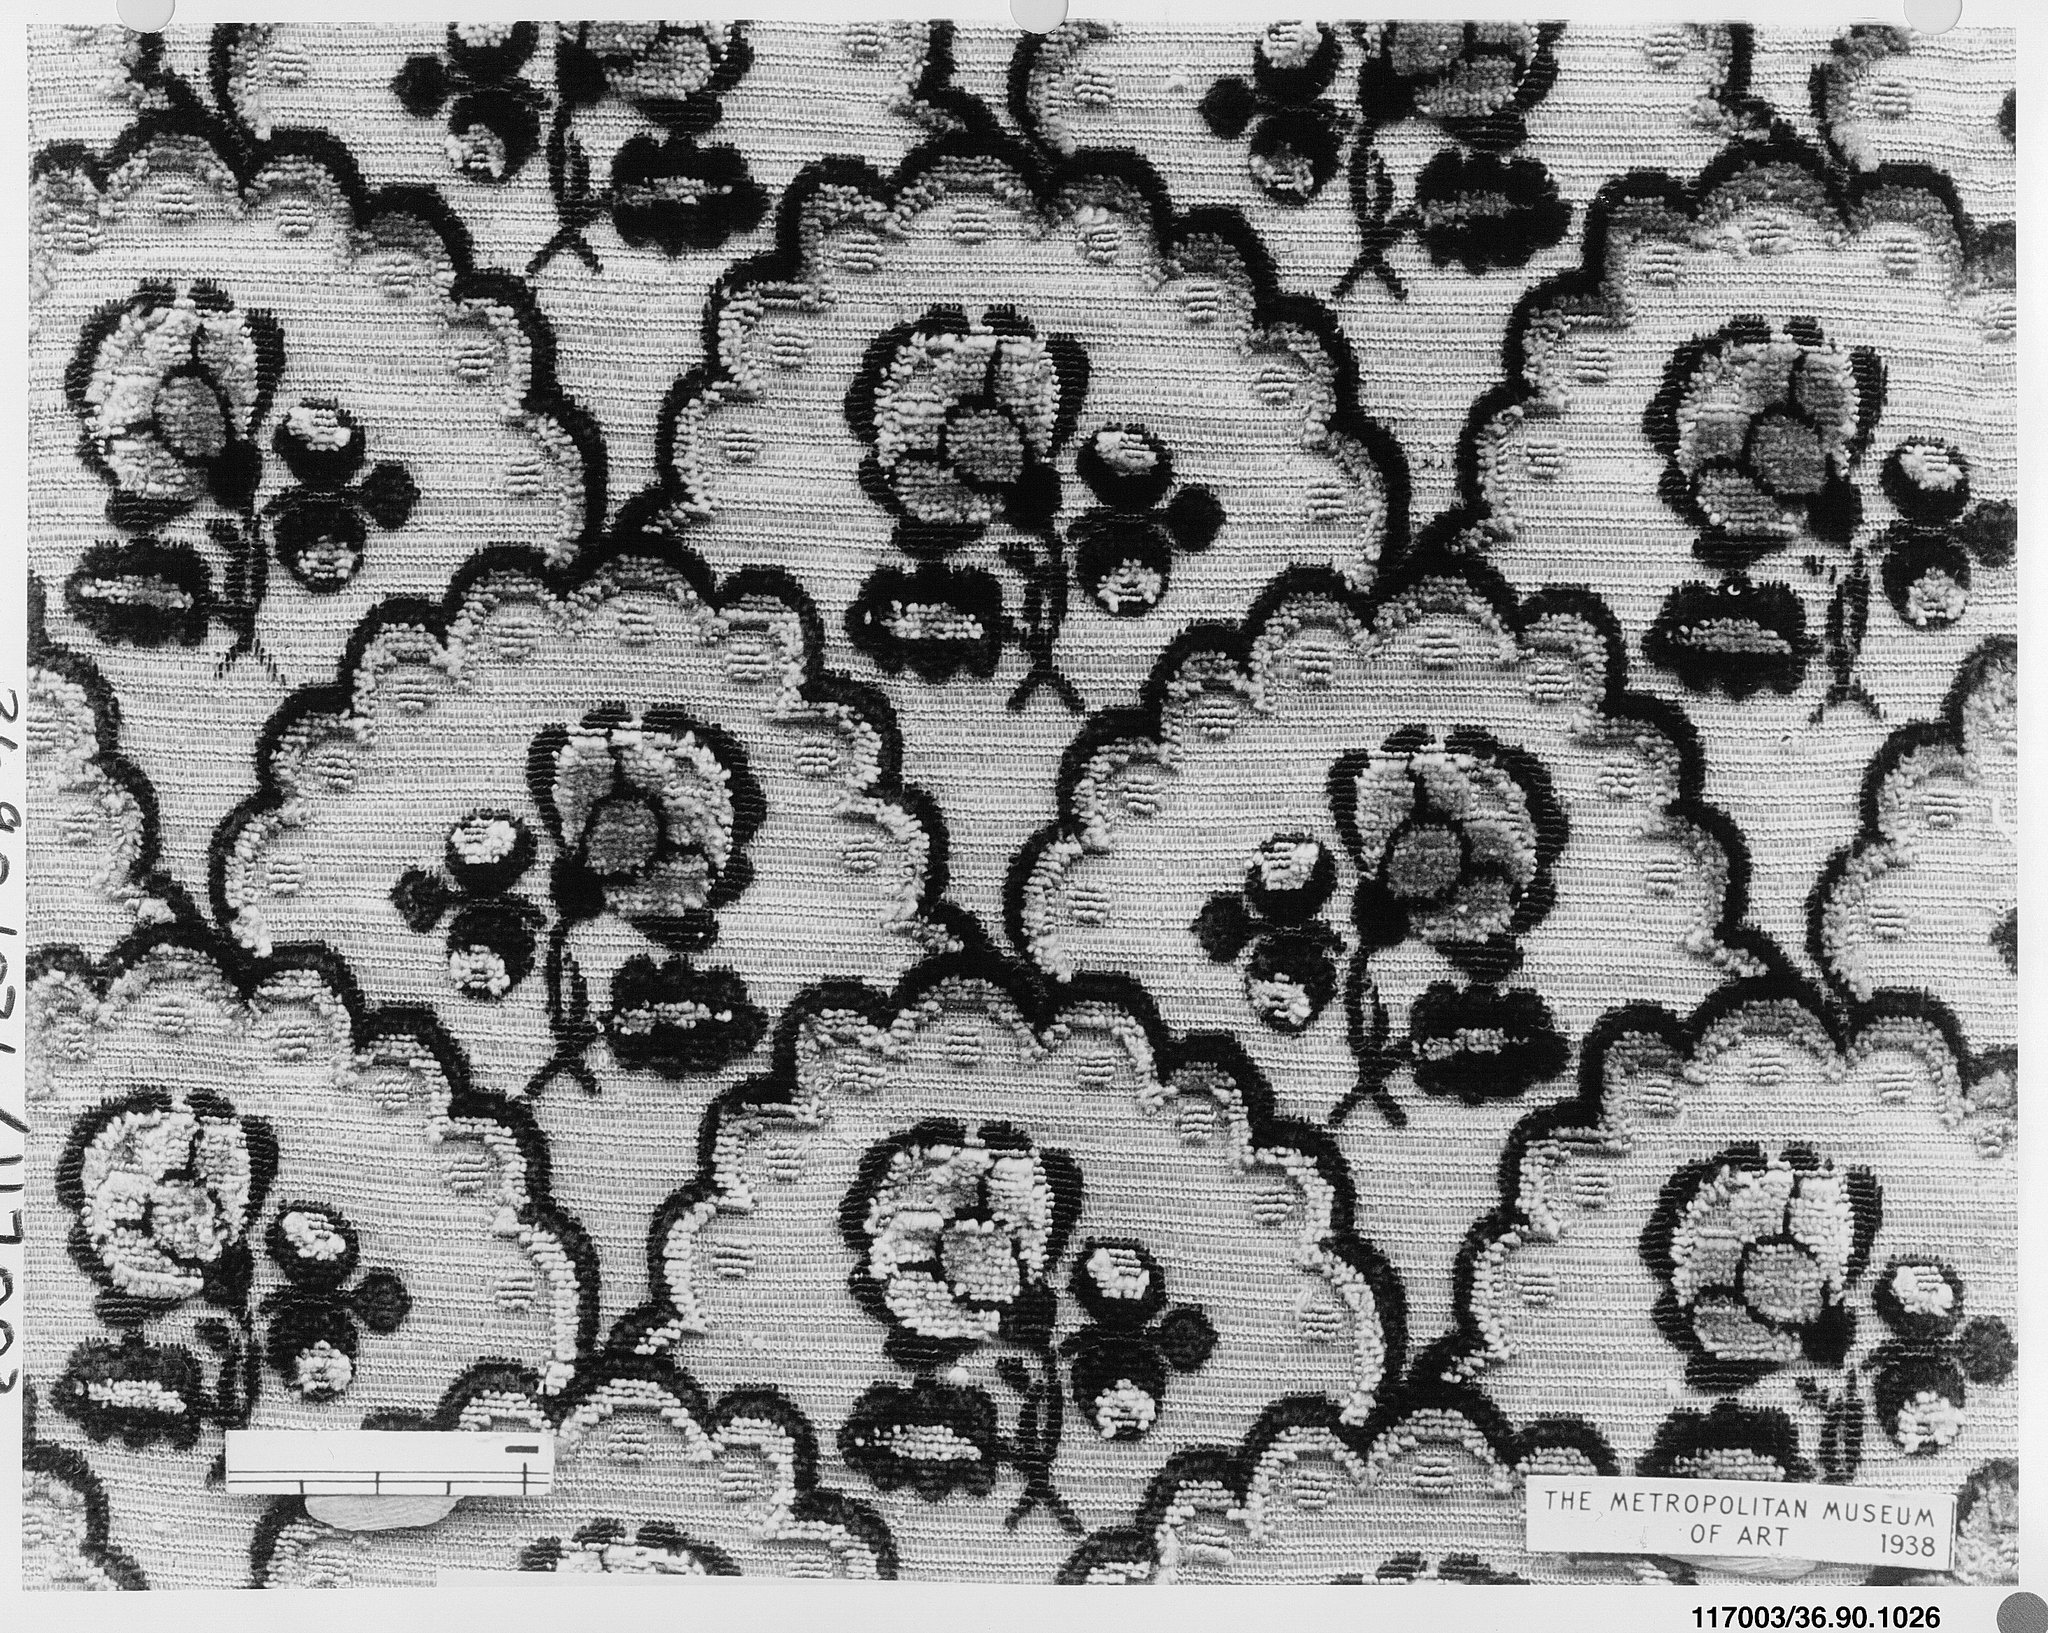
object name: piece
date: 1701-1800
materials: metal thread, silk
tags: flowers,leaves